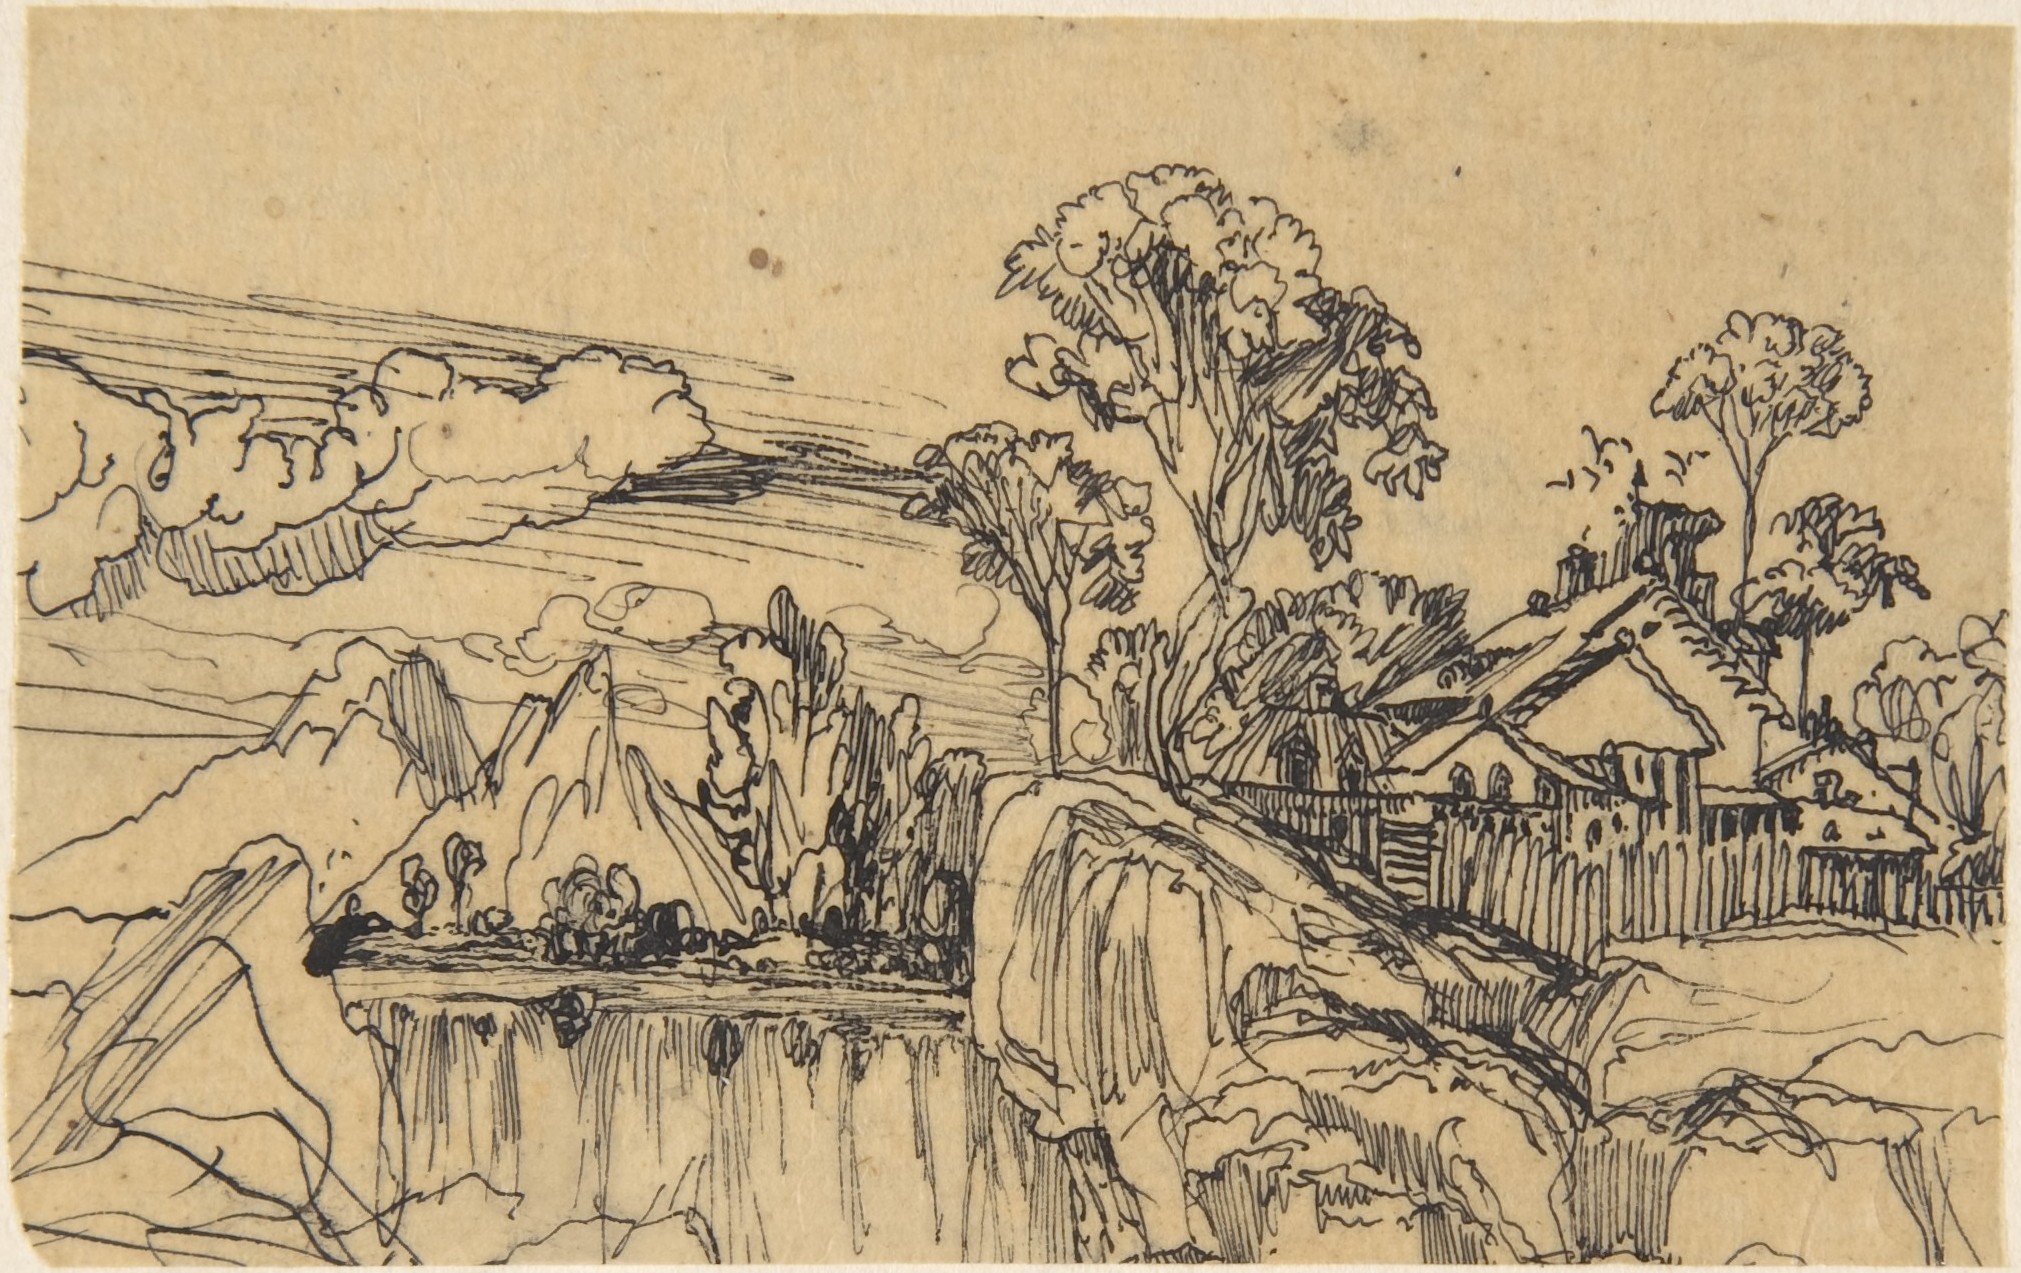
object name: drawing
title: Little Maritime Village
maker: rodolphe bresdin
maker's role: artist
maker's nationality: french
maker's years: 1822-1885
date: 1822-1885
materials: ink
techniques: pen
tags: houses,villages,trees